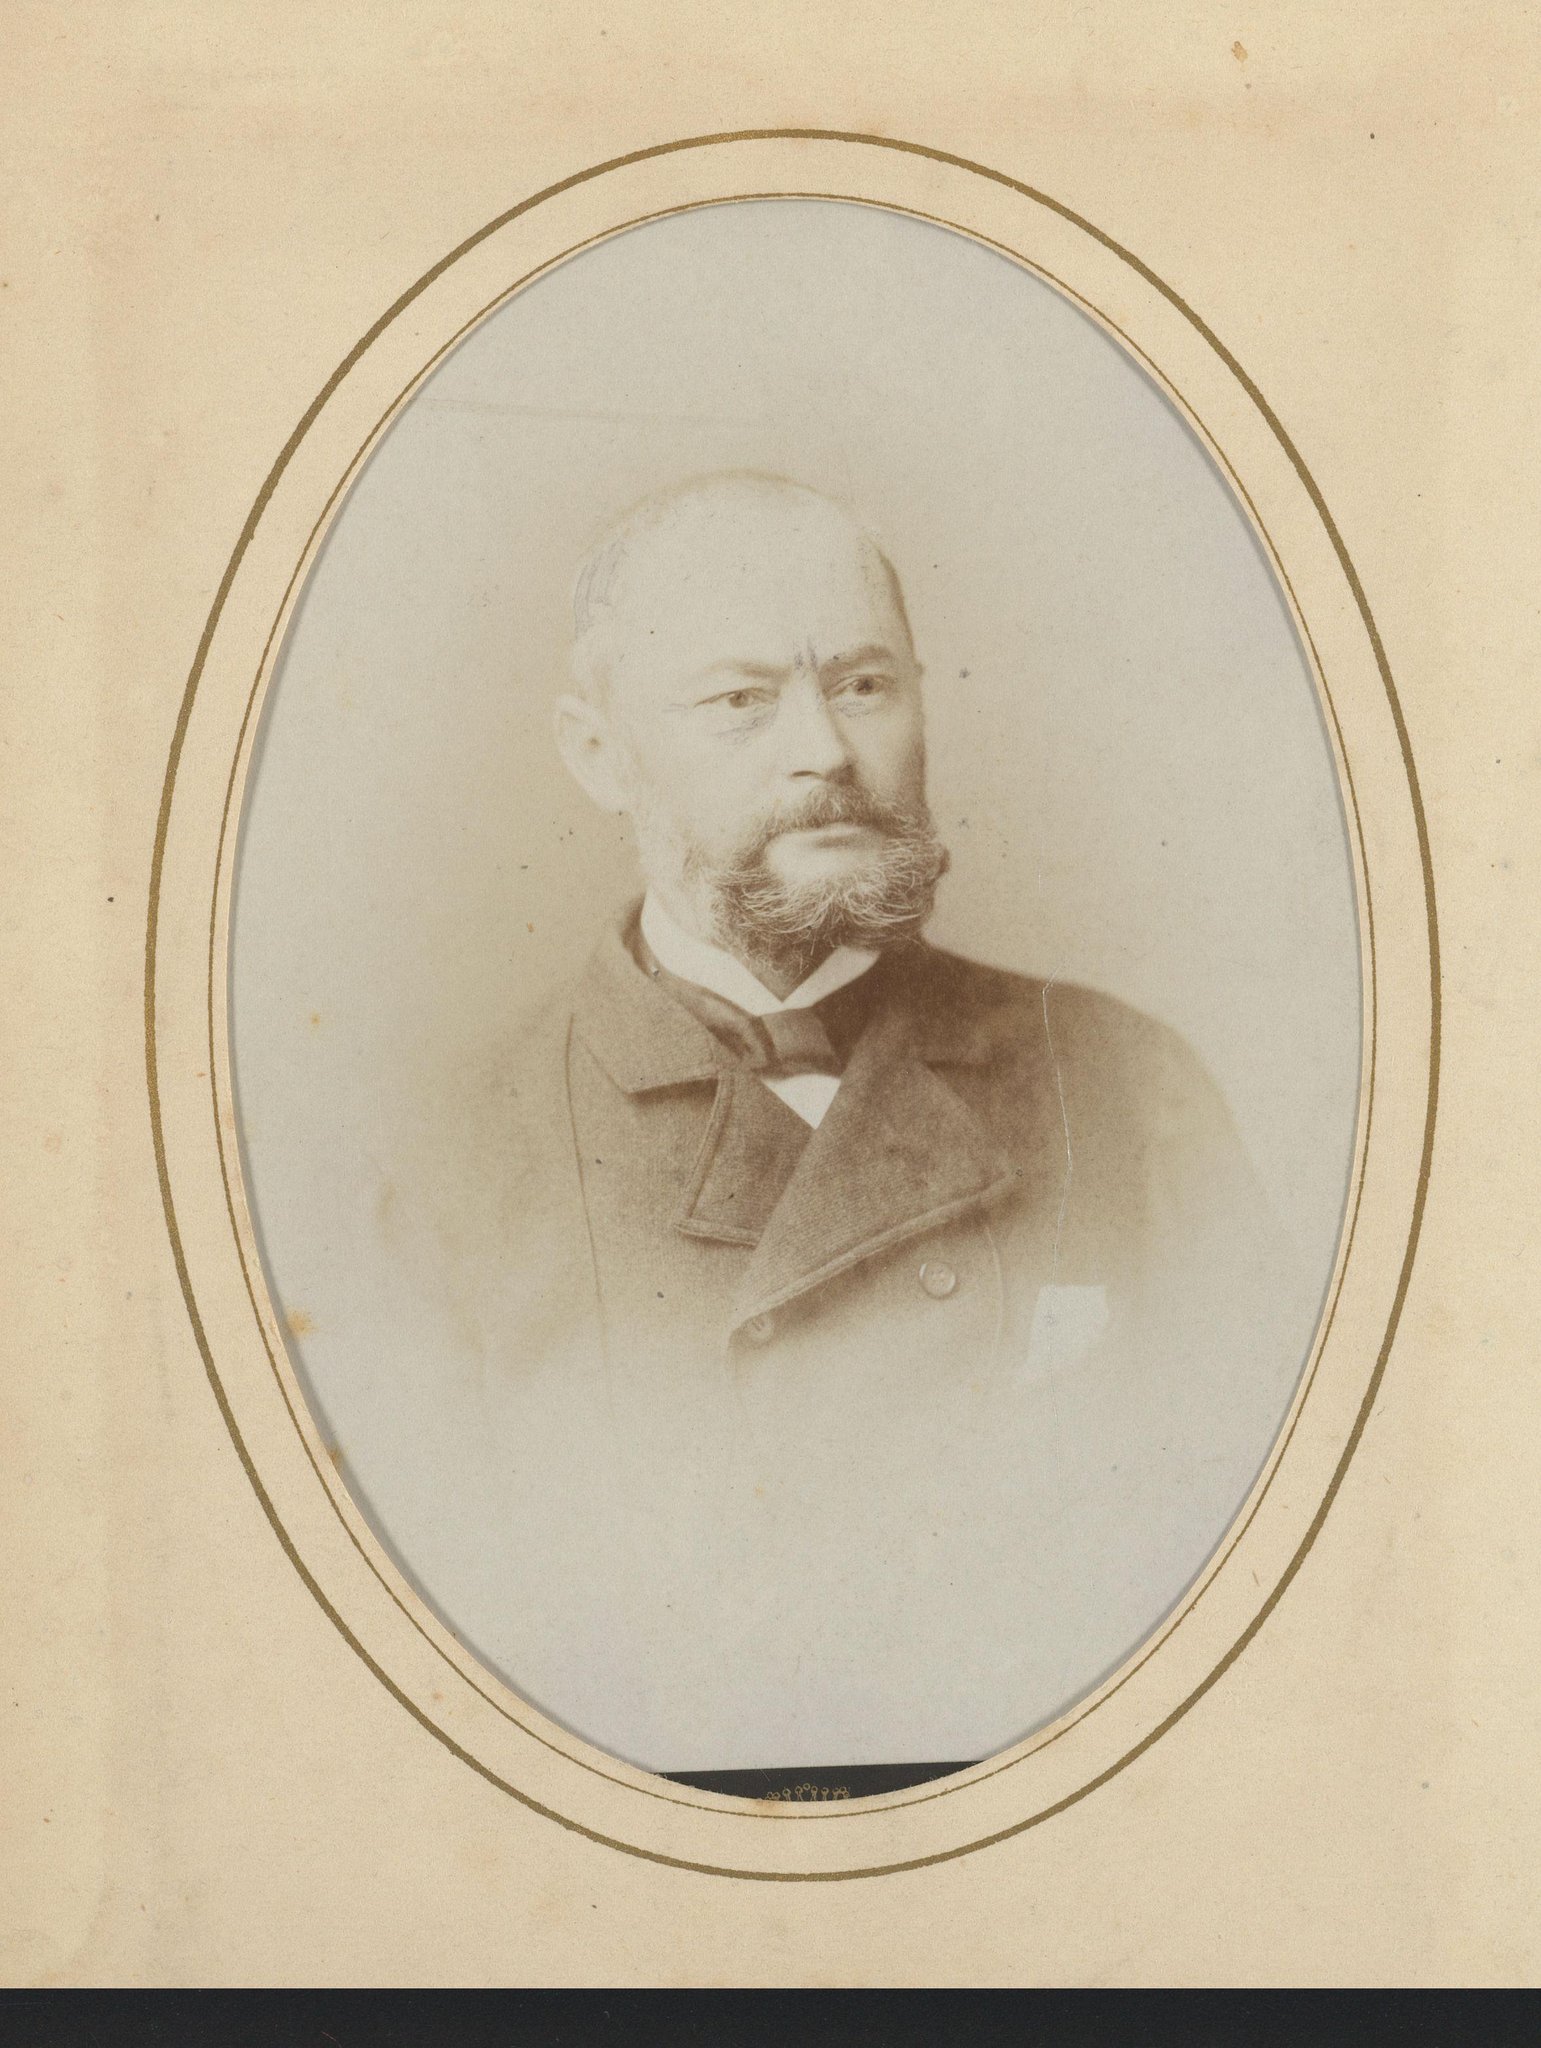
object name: photograph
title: Portret van een man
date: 1864-1886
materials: cardboard, photographic support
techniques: albumen print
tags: adult man, historical persons, beard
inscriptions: inscription: ‘(...)/ Dupont/ 67, Rue Neuve, 67/ Bruxelles/ (...)’